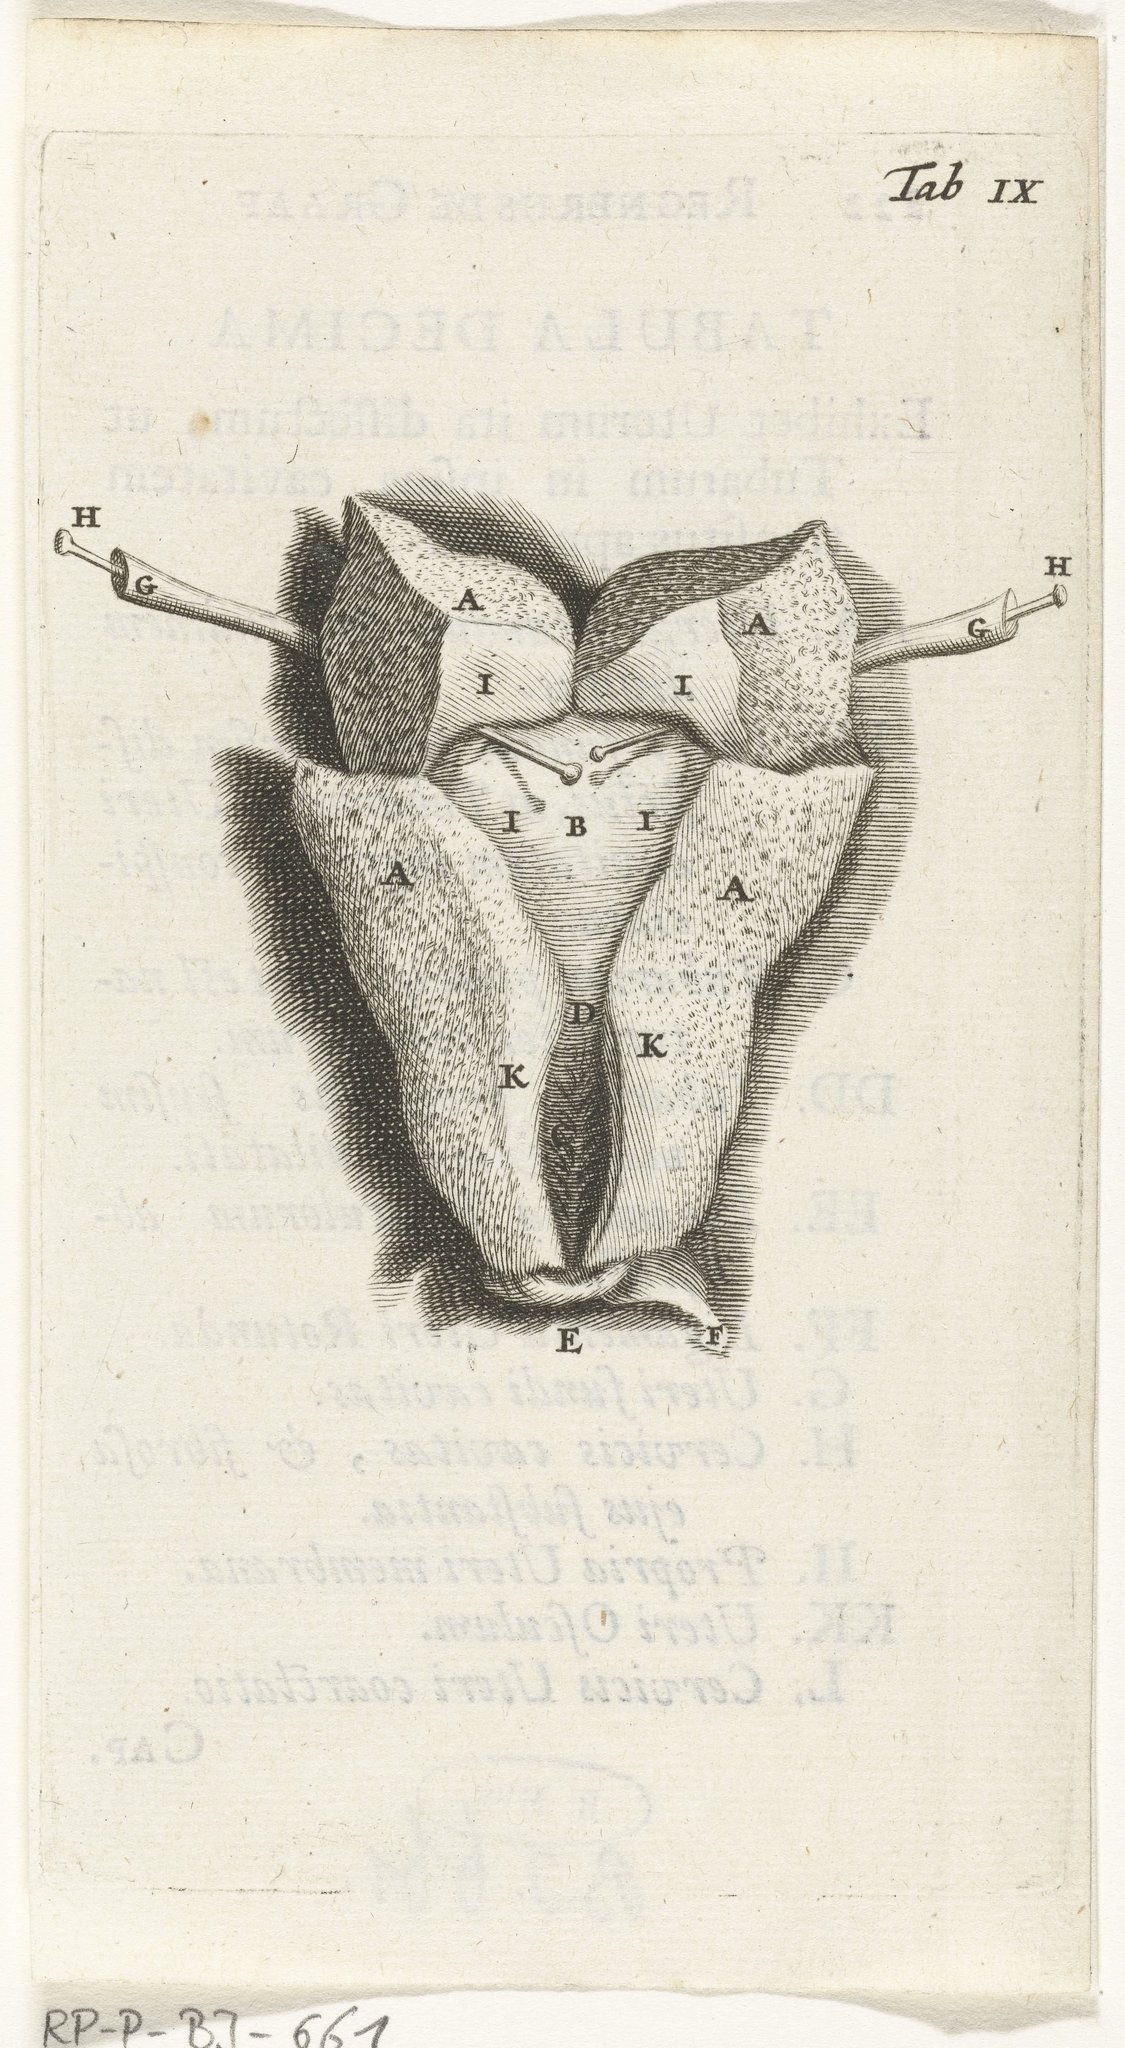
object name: book illustration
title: Prints of the Female Reproductive Organs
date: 1672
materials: paper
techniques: engraving, letterpress printing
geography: netherlands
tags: womb, uterus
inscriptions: collector's mark: Lugt 2228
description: In 1672, physician and anatomist Reinier de Graaf published his De mulierum organis about the female reproductive organs. The book contains detailed prints by Hendrik Bary, among them several of the vagina. De Graaf was the first to conclude that a foetus was the product not just of a man’s seed, but also of a woman’s egg. He discovered what he called blisters, which later became known as Graafian follicles.